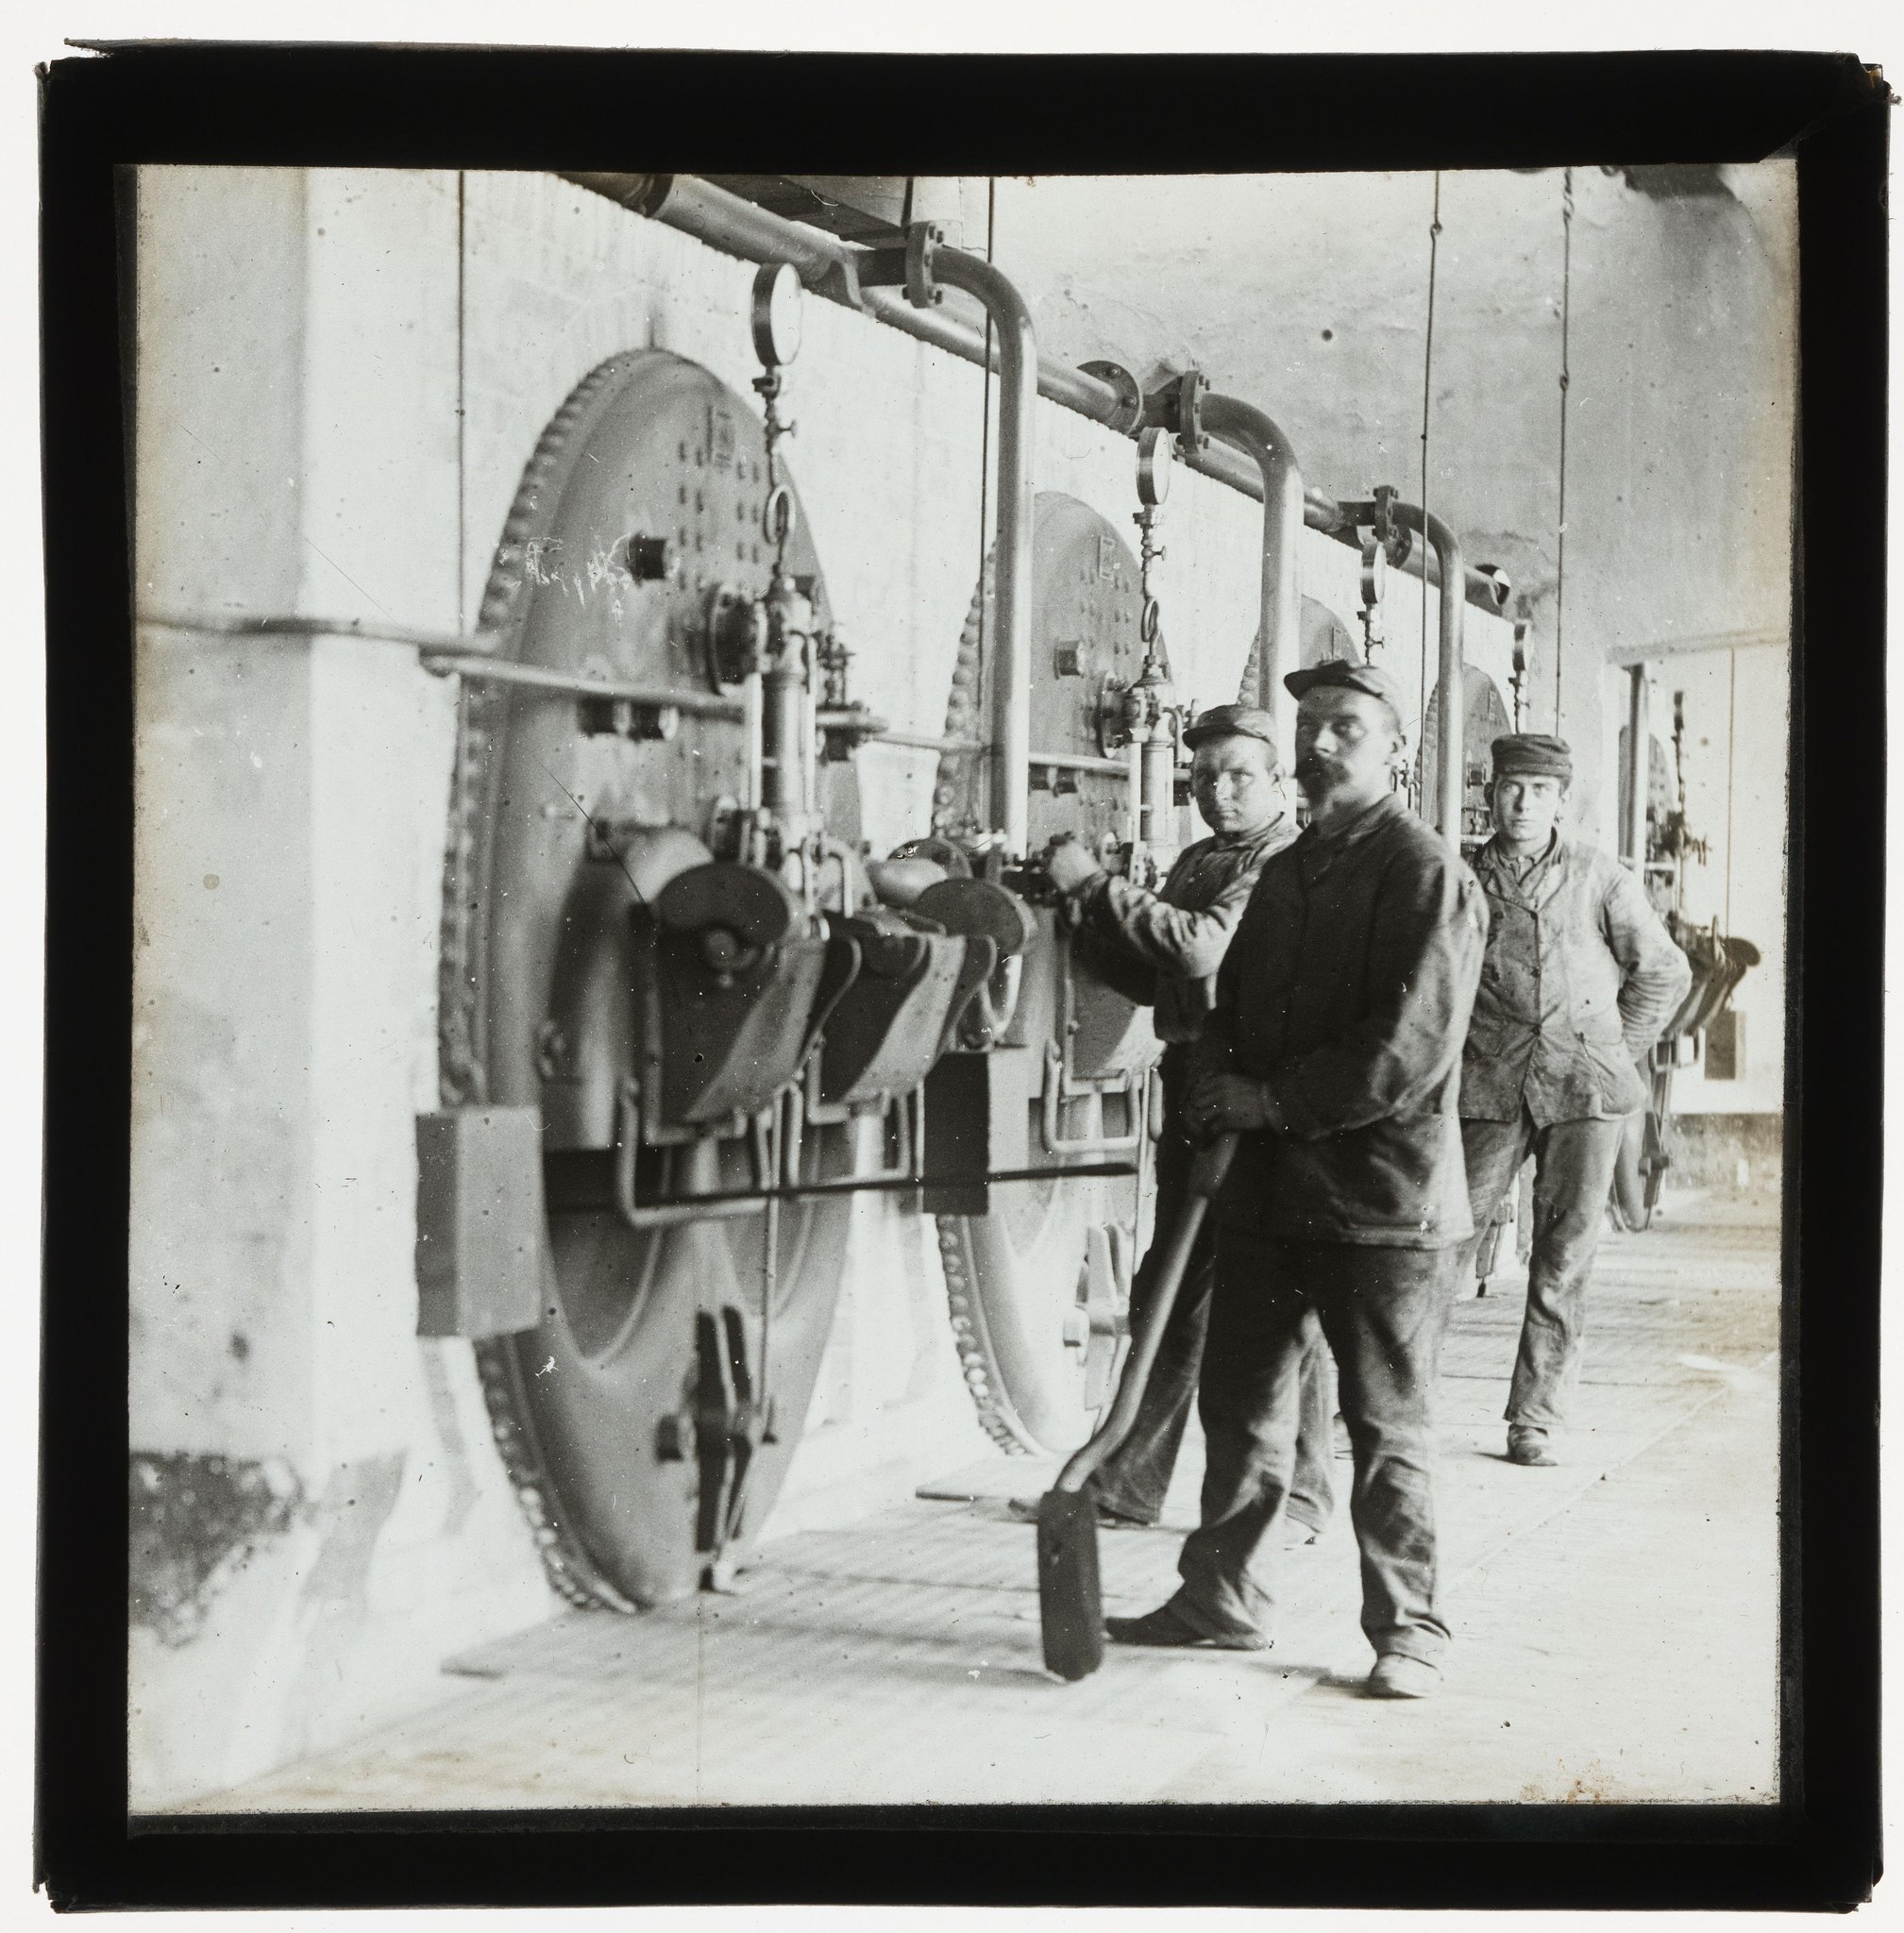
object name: lantern slide photographic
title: Fabrieksmedewerkers bij stoommachines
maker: machiel gerrit george suyver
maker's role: fotograaf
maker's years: 1872-1933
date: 1893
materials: glass, paper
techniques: gelatin silver transparency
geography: lijnden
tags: machines, engines ~ crafts and industries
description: Gemaal Lynden, proefstomen 2e generatie 6 stoomketels, door H&J Suyver.